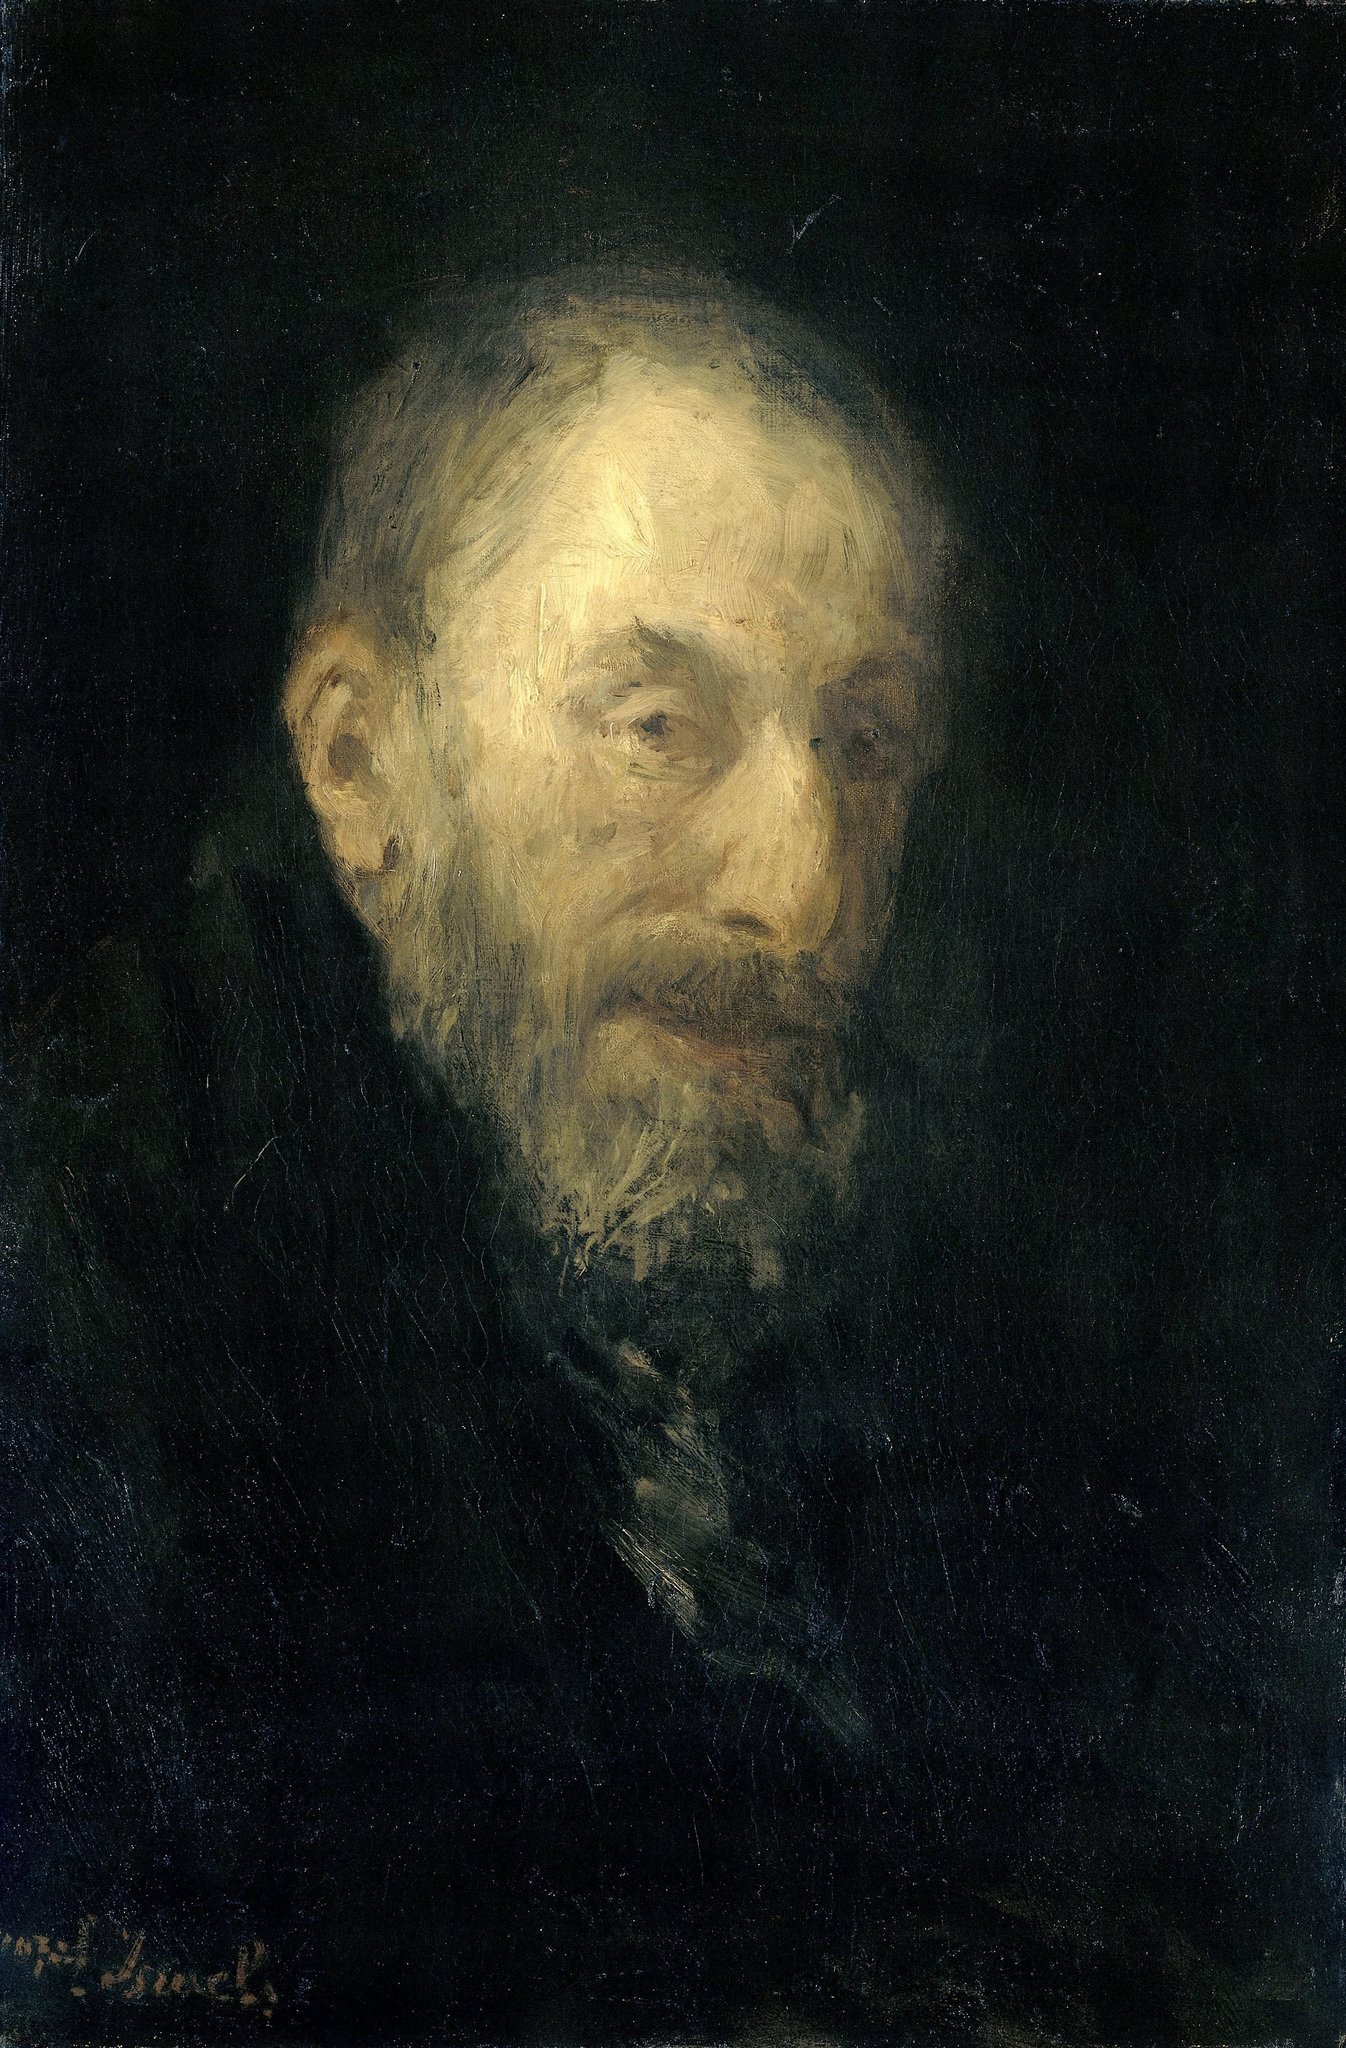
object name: painting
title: 'Old Isaac'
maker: jozef israëls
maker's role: draughtsman, painter, print maker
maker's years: 1824-1911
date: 1896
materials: canvas, oil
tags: historical persons, old man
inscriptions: signature: ‘Jozef Israels’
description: 'De oude Isaac'. Studie van een oude man met baard, borstbeeld, naar rechts.